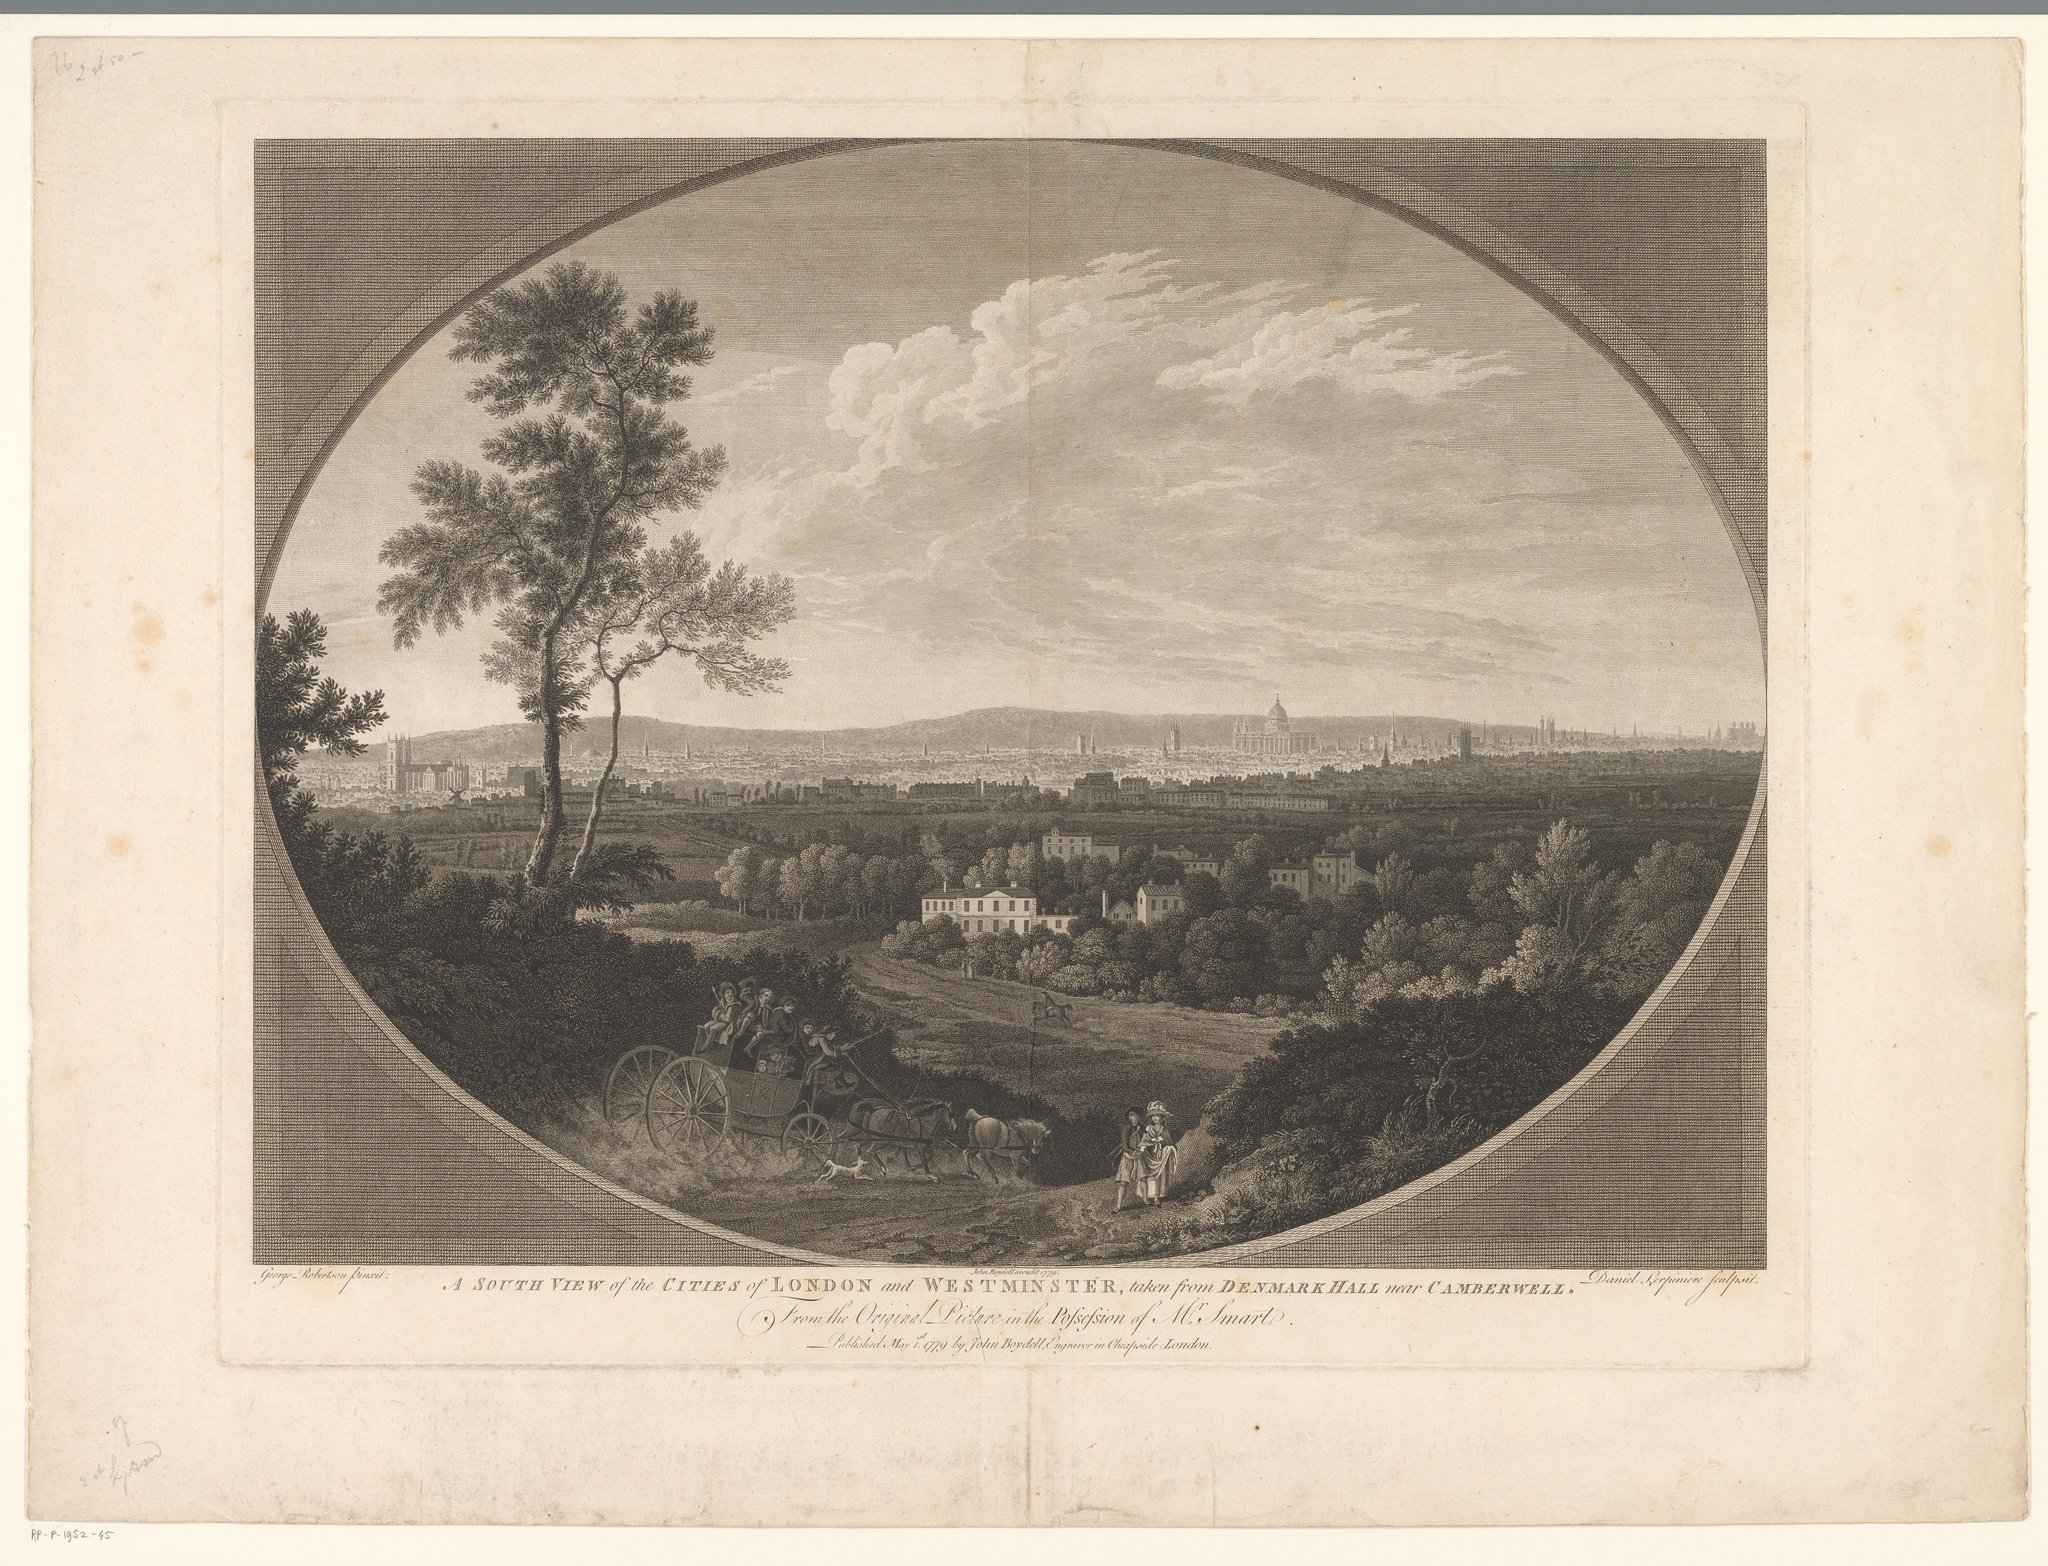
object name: print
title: Figuren in en op een koets met op de achtergrond een gezicht op Londen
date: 1779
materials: paper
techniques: engraving, etching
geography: london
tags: outskirts of city, passenger carriage, london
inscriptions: collector's mark: Lugt 2228